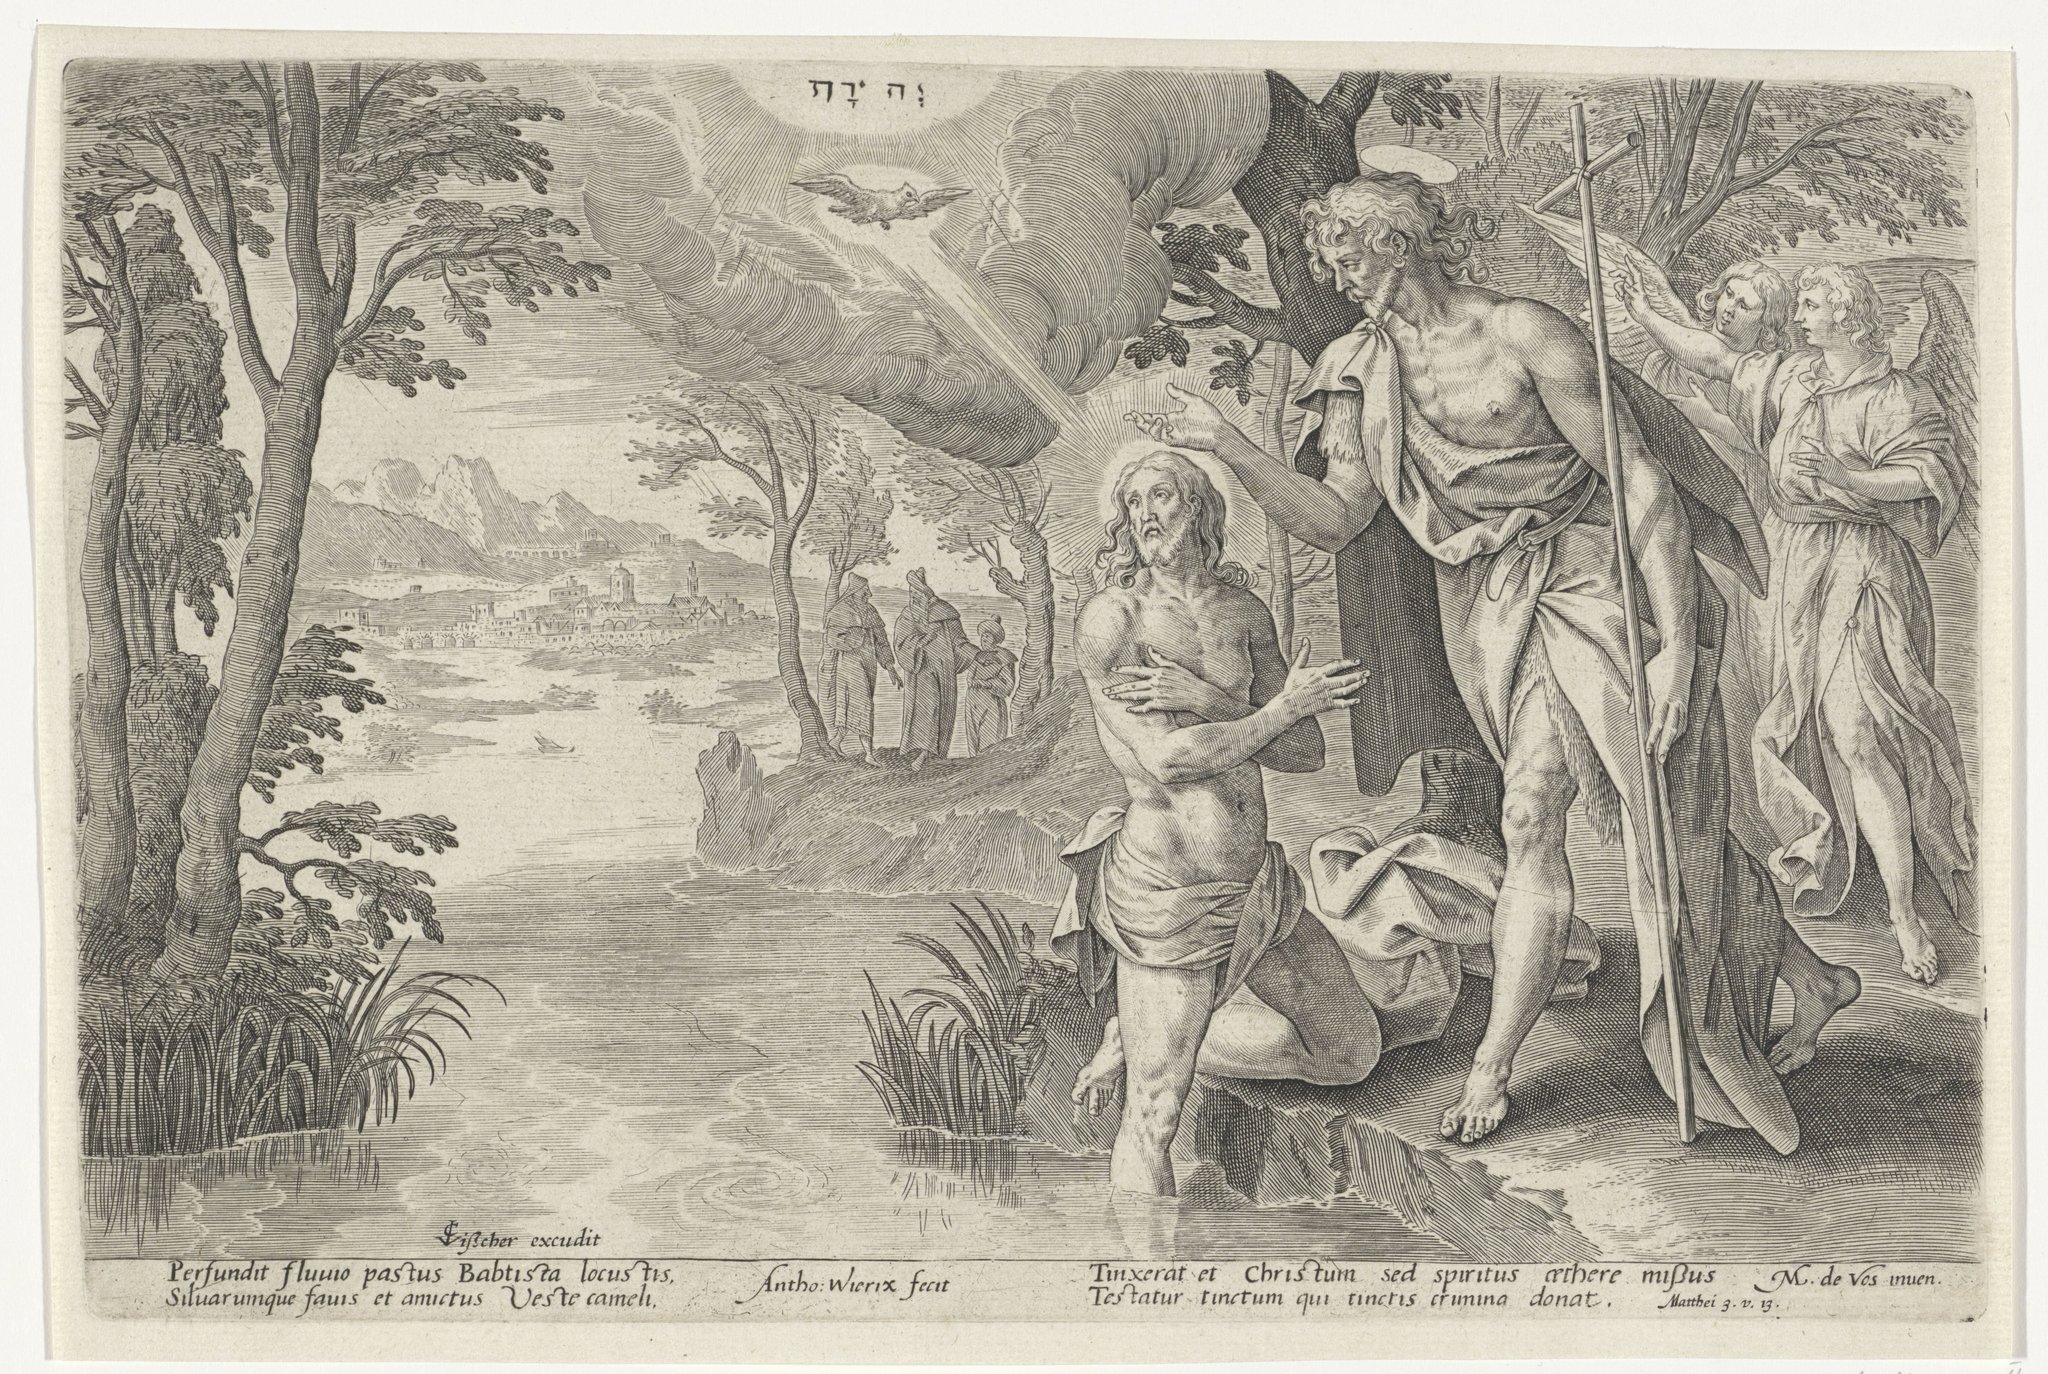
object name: print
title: Theatrum biblicum (...)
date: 1585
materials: paper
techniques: engraving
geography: antwerp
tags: baptism of christ in the river jordan: john the baptist pouring out water on christ's head: the holy ghost descends, tetragram (in roman or hebrew script) ~ symbol of god the father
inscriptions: collector's mark: Lugt 2228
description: Christus wordt door Johannes de Doper, in het bijzijn van twee engelen, in de Jordaan gedoopt. Eén van hen wijst naar het tetragram - symbool van God de Vader - dat aan de hemel is verschenen nadat Christus uit het water omhoog kwam. God in de gedaante van een duif daalt op hem neer. Onder de voorstelling een verwijzing in het Latijn naar de Bijbeltekst in Mat. 3:13.